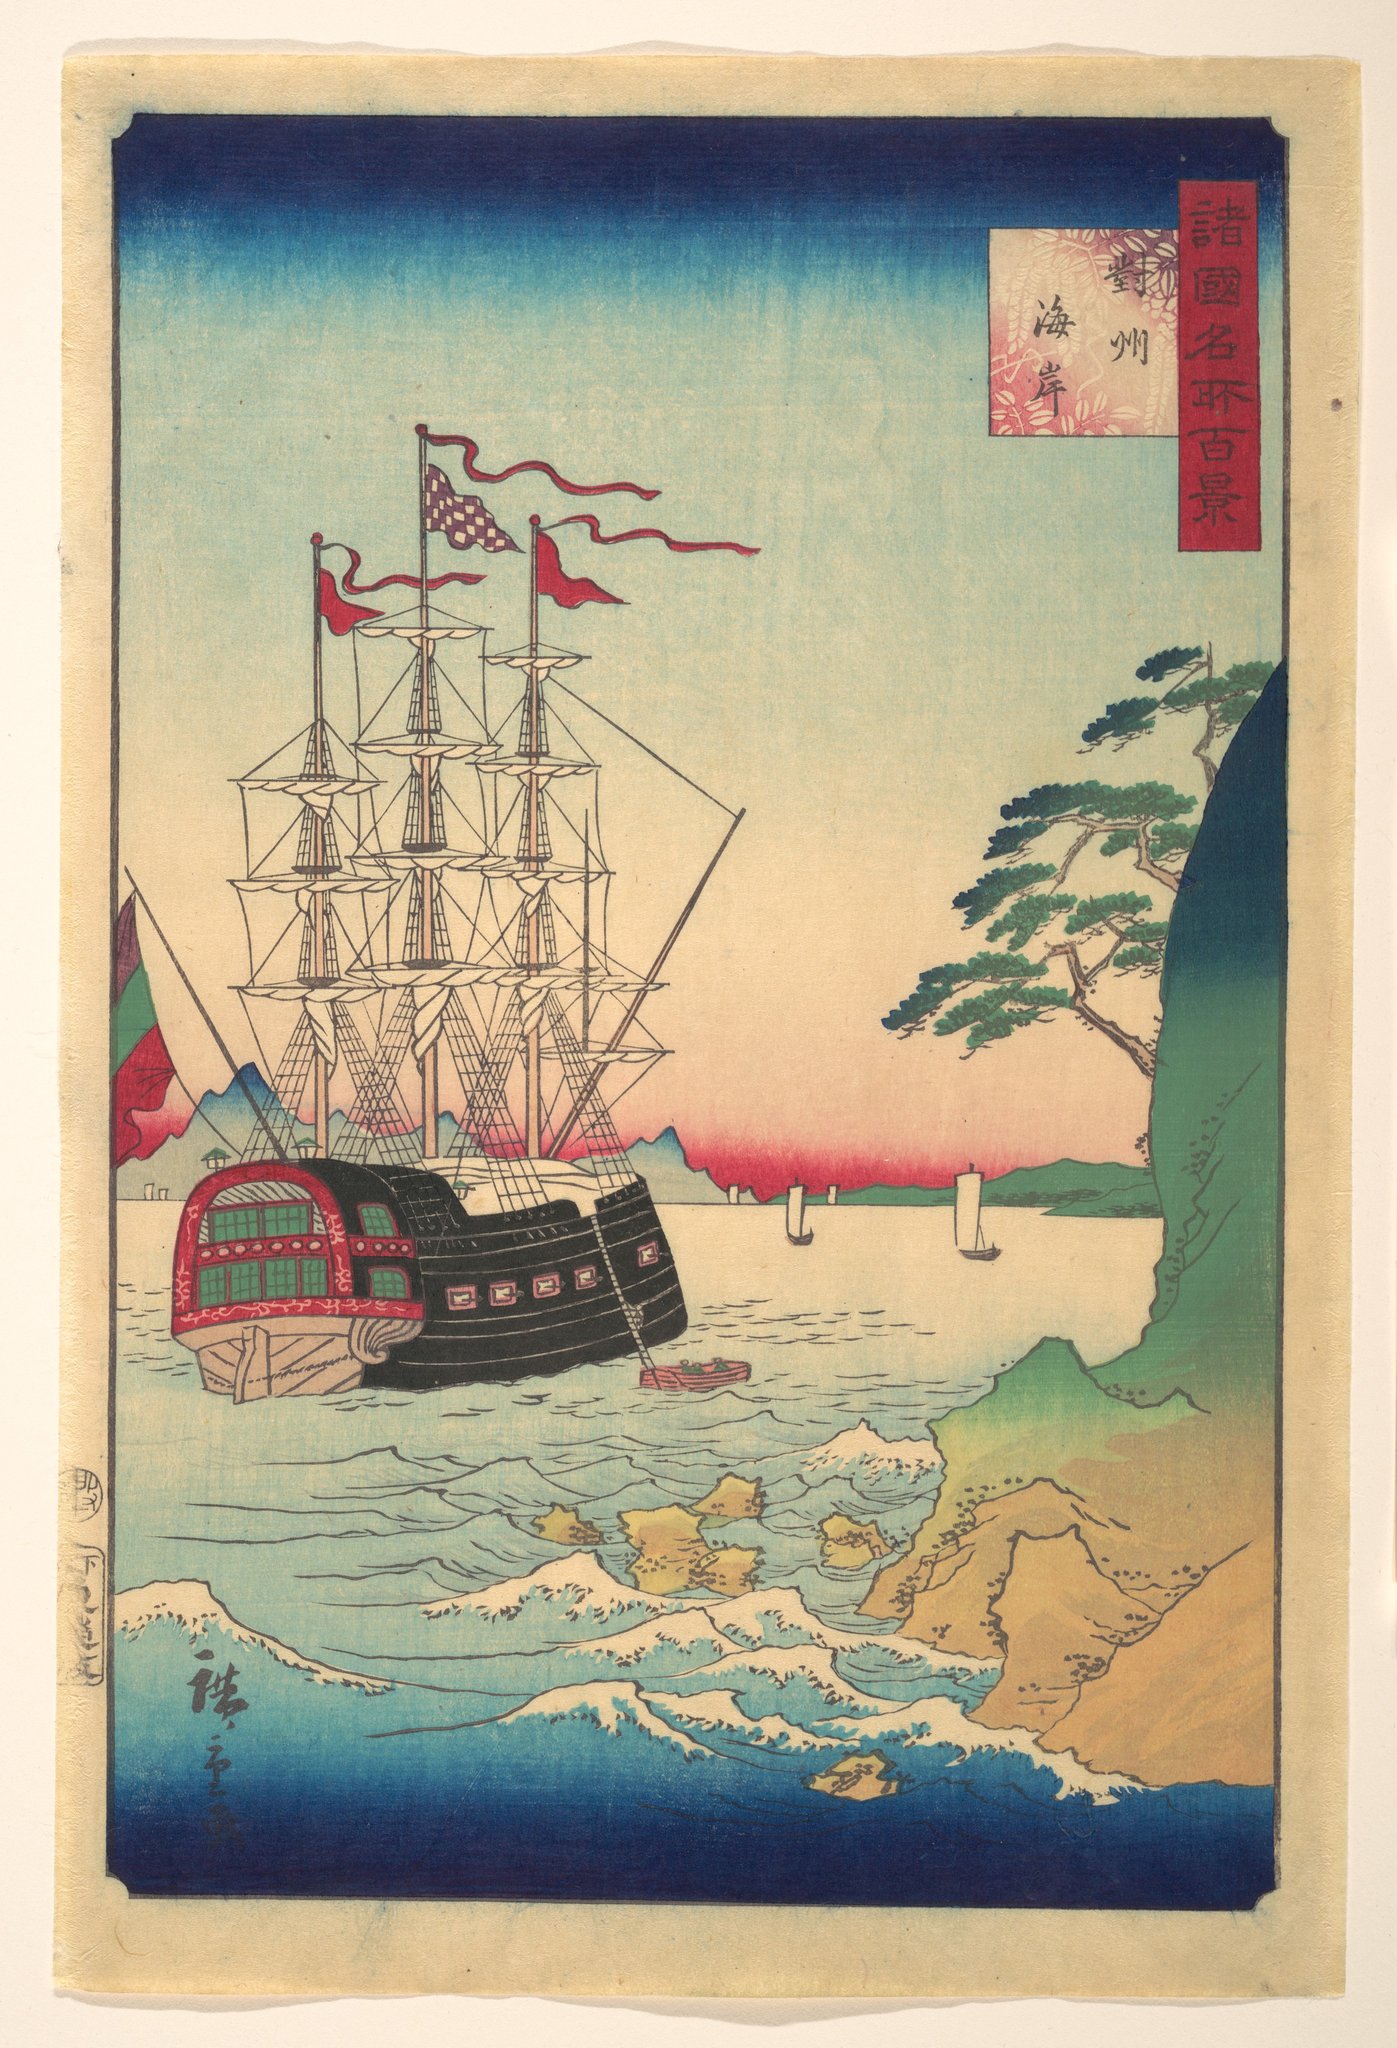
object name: print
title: Dutch Ship at Anchor off the Coast of Tsushima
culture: japanese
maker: utagawa hiroshige ii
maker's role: artist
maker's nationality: japanese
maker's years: 1826-1869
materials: ink, paper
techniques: woodblock print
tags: ships